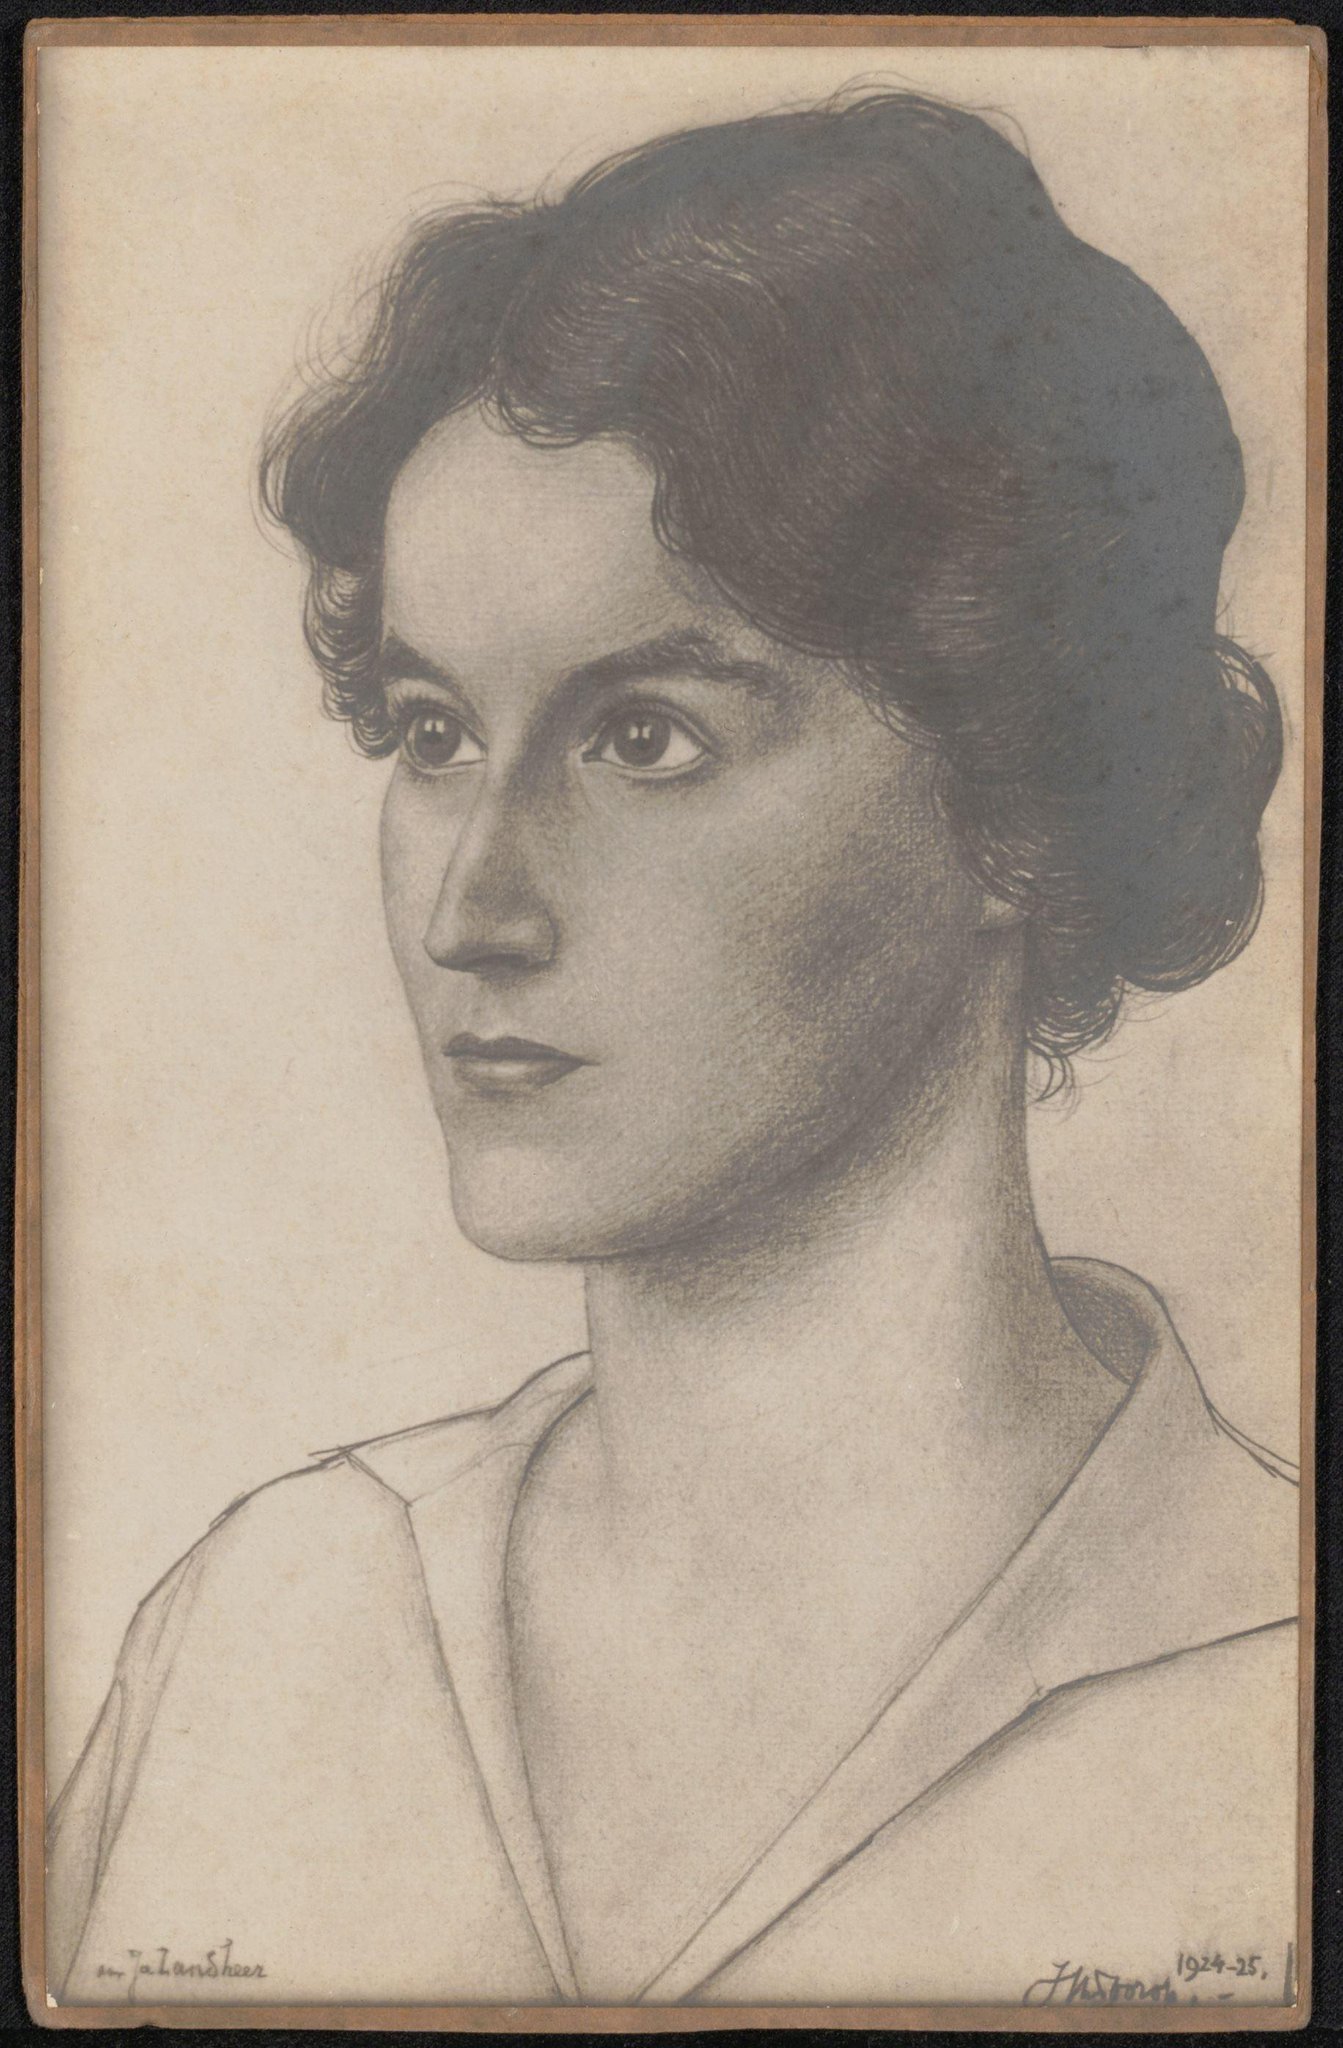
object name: photograph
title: Fotoreproductie aan Jenny Kraft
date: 1927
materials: cardboard, photographic support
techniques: gelatin silver print, pen, writing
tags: jo landheer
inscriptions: : ‘aan Jenny Kraft/ van Jan Toorop / 16 April 1927/ met sympathie’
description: Fotoreproductie van een tekening voorstellende een portret van Jo Landheer. Bij de foto wordt documentatie bewaard.